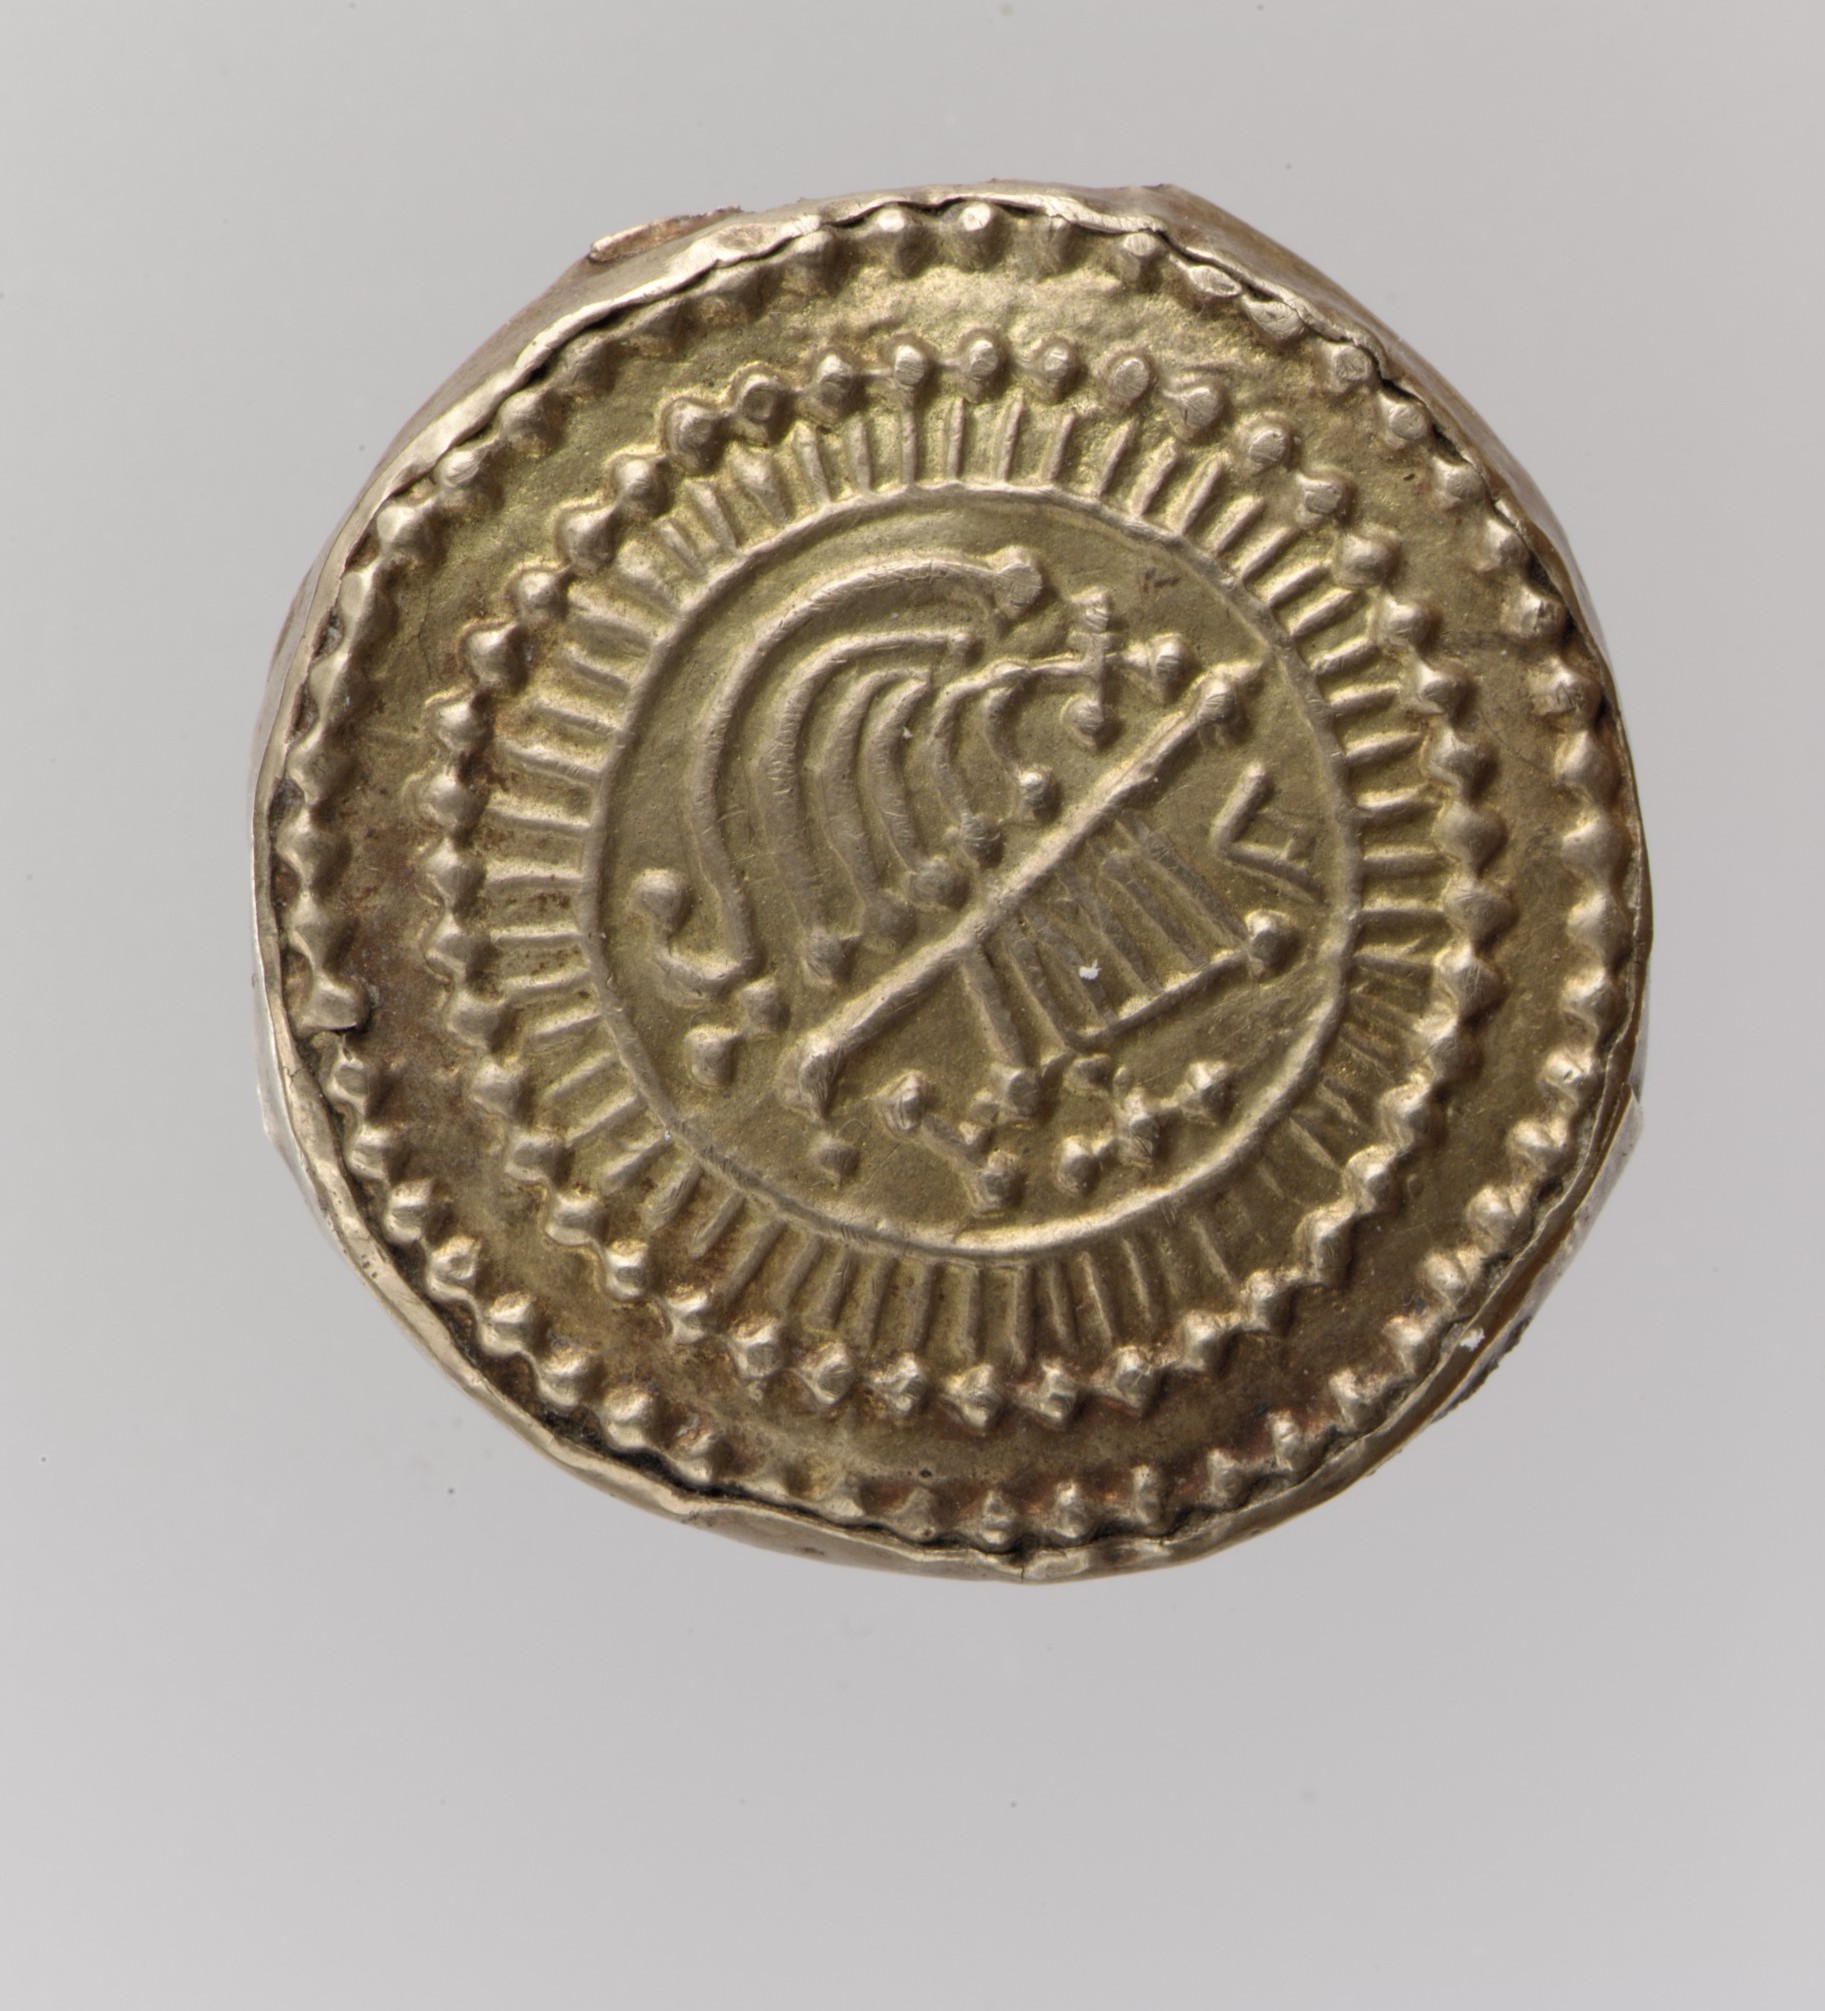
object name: brooch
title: Gold Disk Brooch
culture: frankish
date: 601-700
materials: copper alloy, gold